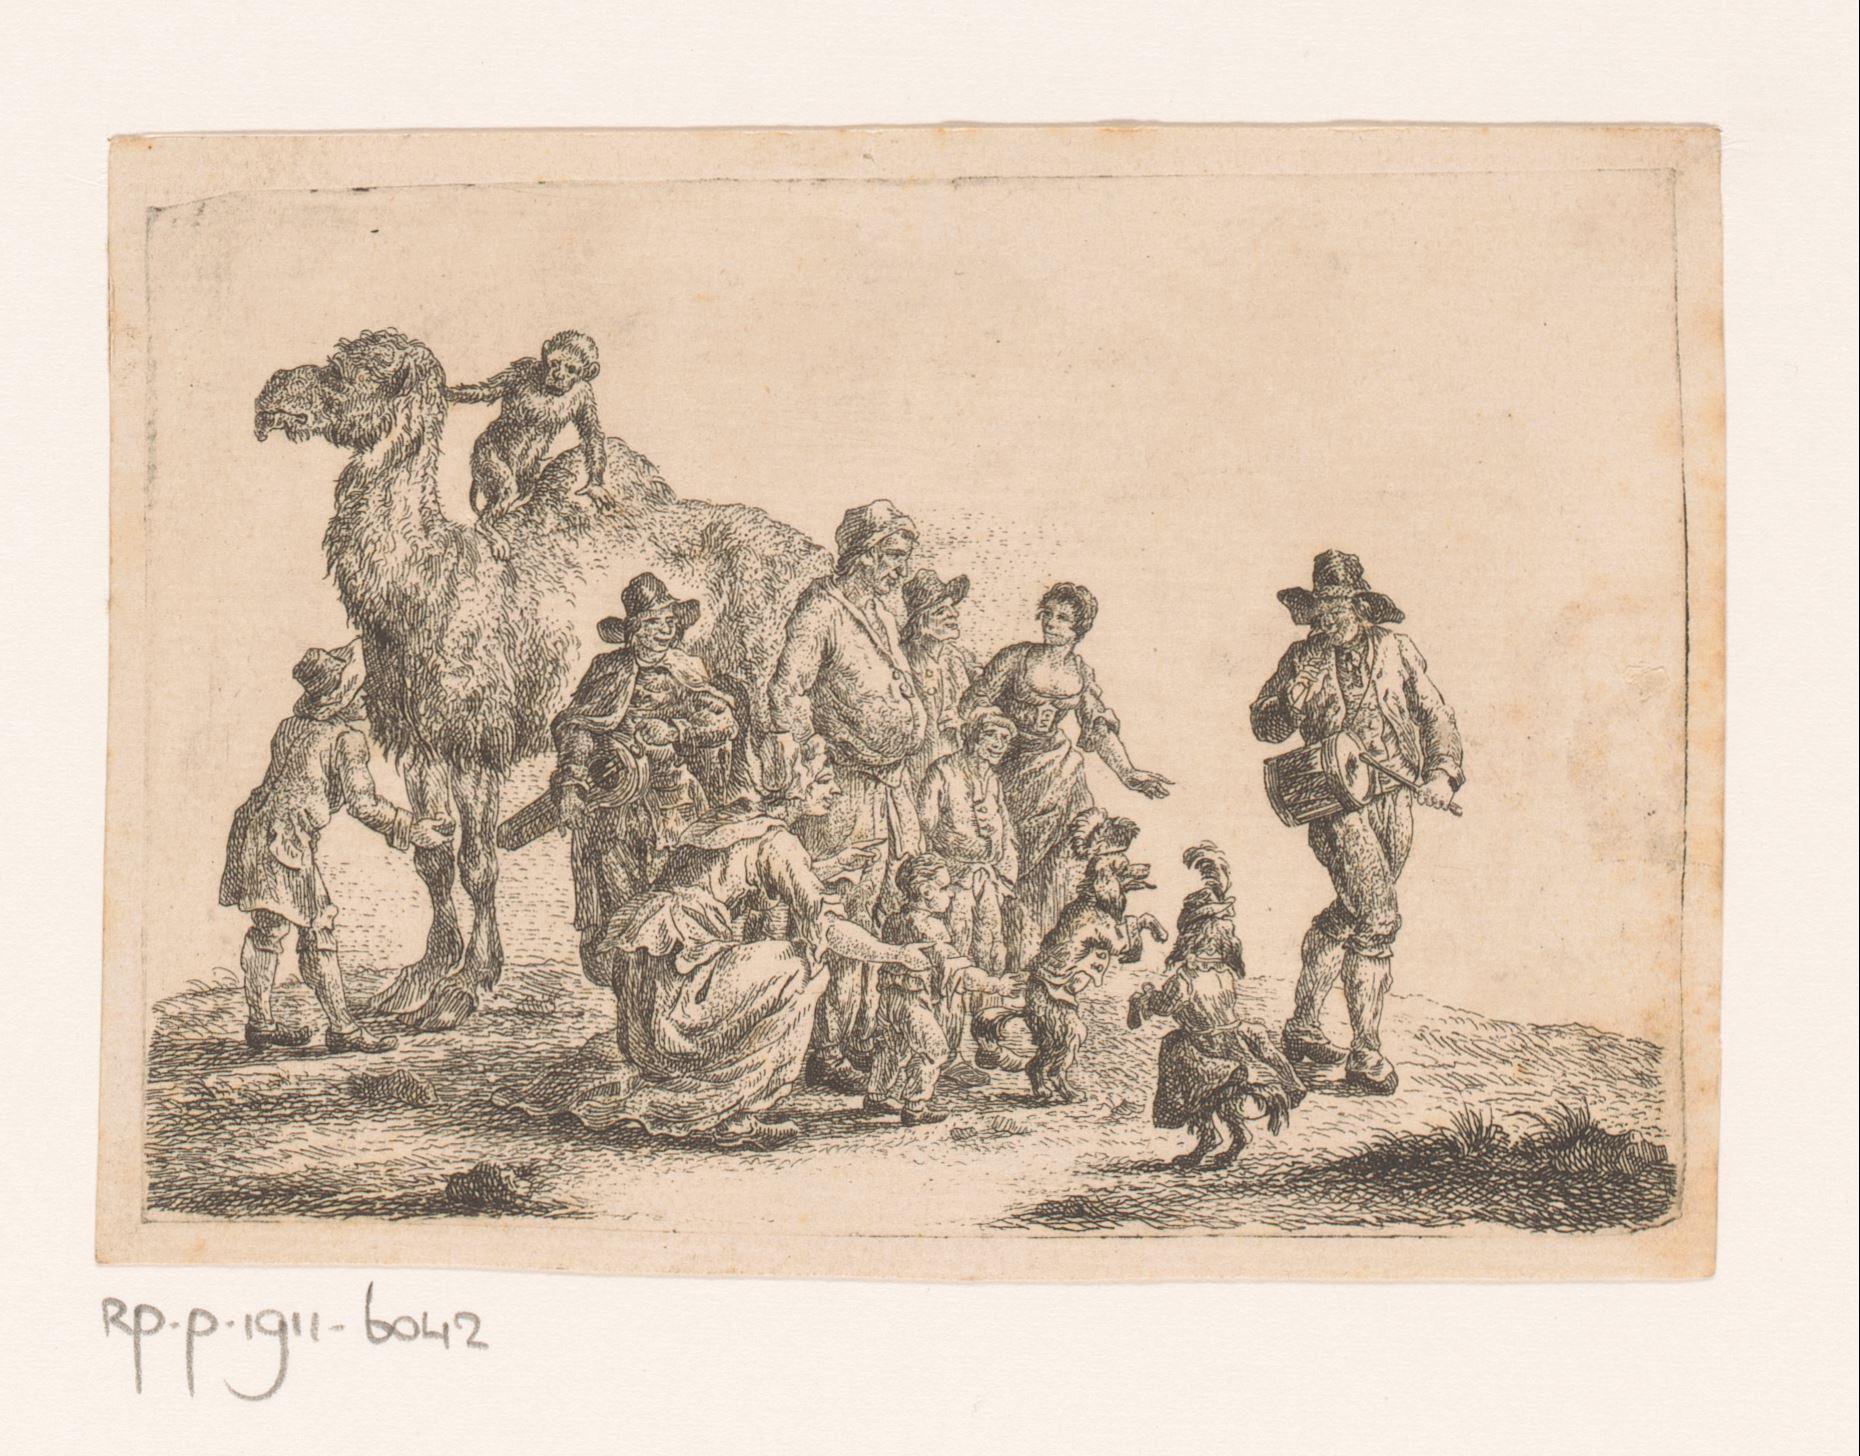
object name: print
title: Muzikanten met een draailier en een trommel laten honden dansen voor publiek, op de achtergrond een dromedaris met een aap op de rug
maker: pierre-françois le roy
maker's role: draughtsman, painter, print maker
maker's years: 1771-1862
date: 1794-1862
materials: paper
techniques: etching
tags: training of performing dog, hoofed animals: dromedary, monkeys, apes, hurdy-gurdy player - cc - out of doors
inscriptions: collector's mark: Lugt 1485, collector's mark: Lugt 2228